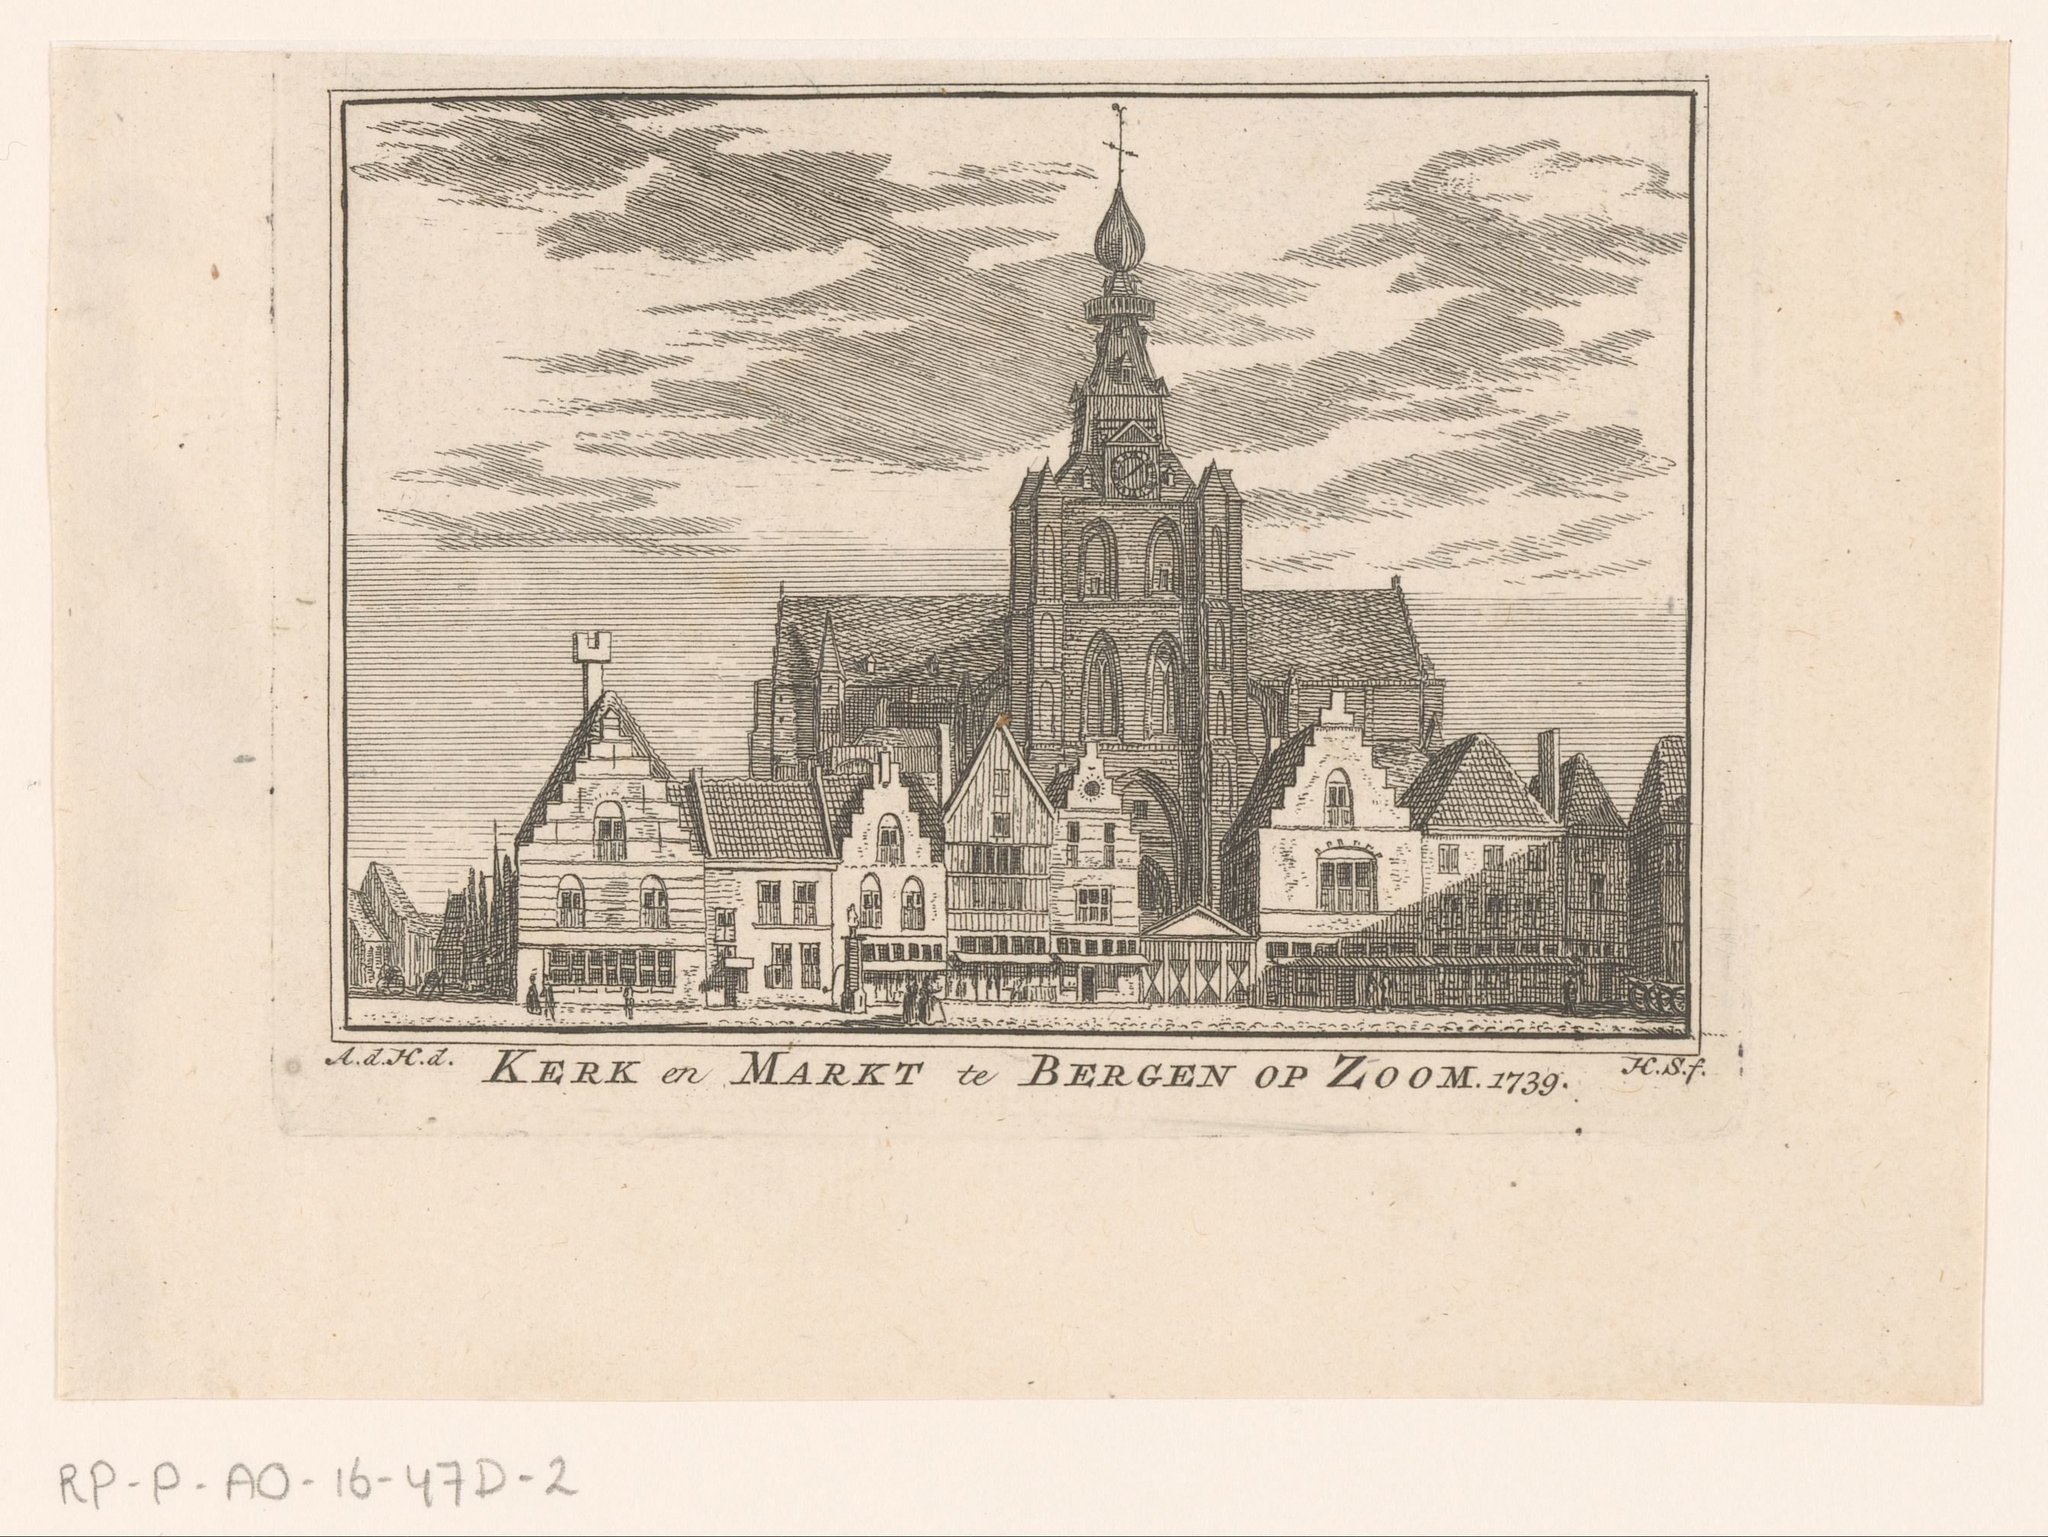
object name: print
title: Gezicht op de kerk en markt te Bergen op Zoom, 1739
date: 1745-1792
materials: paper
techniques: engraving, etching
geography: haarlem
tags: church (exterior), market, bergen op zoom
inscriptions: collector's mark: Lugt 2228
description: Prent ook gebruikt in: Het verheerlykt Nederland of kabinet van hedendaagsche gezigten van steden, dorpen (…). 9 delen. Amsterdam: Isaak Tirion en weduwe Isaak Tirion, 1745-1774, dl. 1 (1745), ill. 6. Of in: Nederlandsche tafereelen; of eene keurige verzameling van negen honderd fraaije gezigten van steden, dorpen, sloten, oudheden (….). 9 delen. Amsterdam: Jan de Groot, 1792, dl. 1, ill. 6.